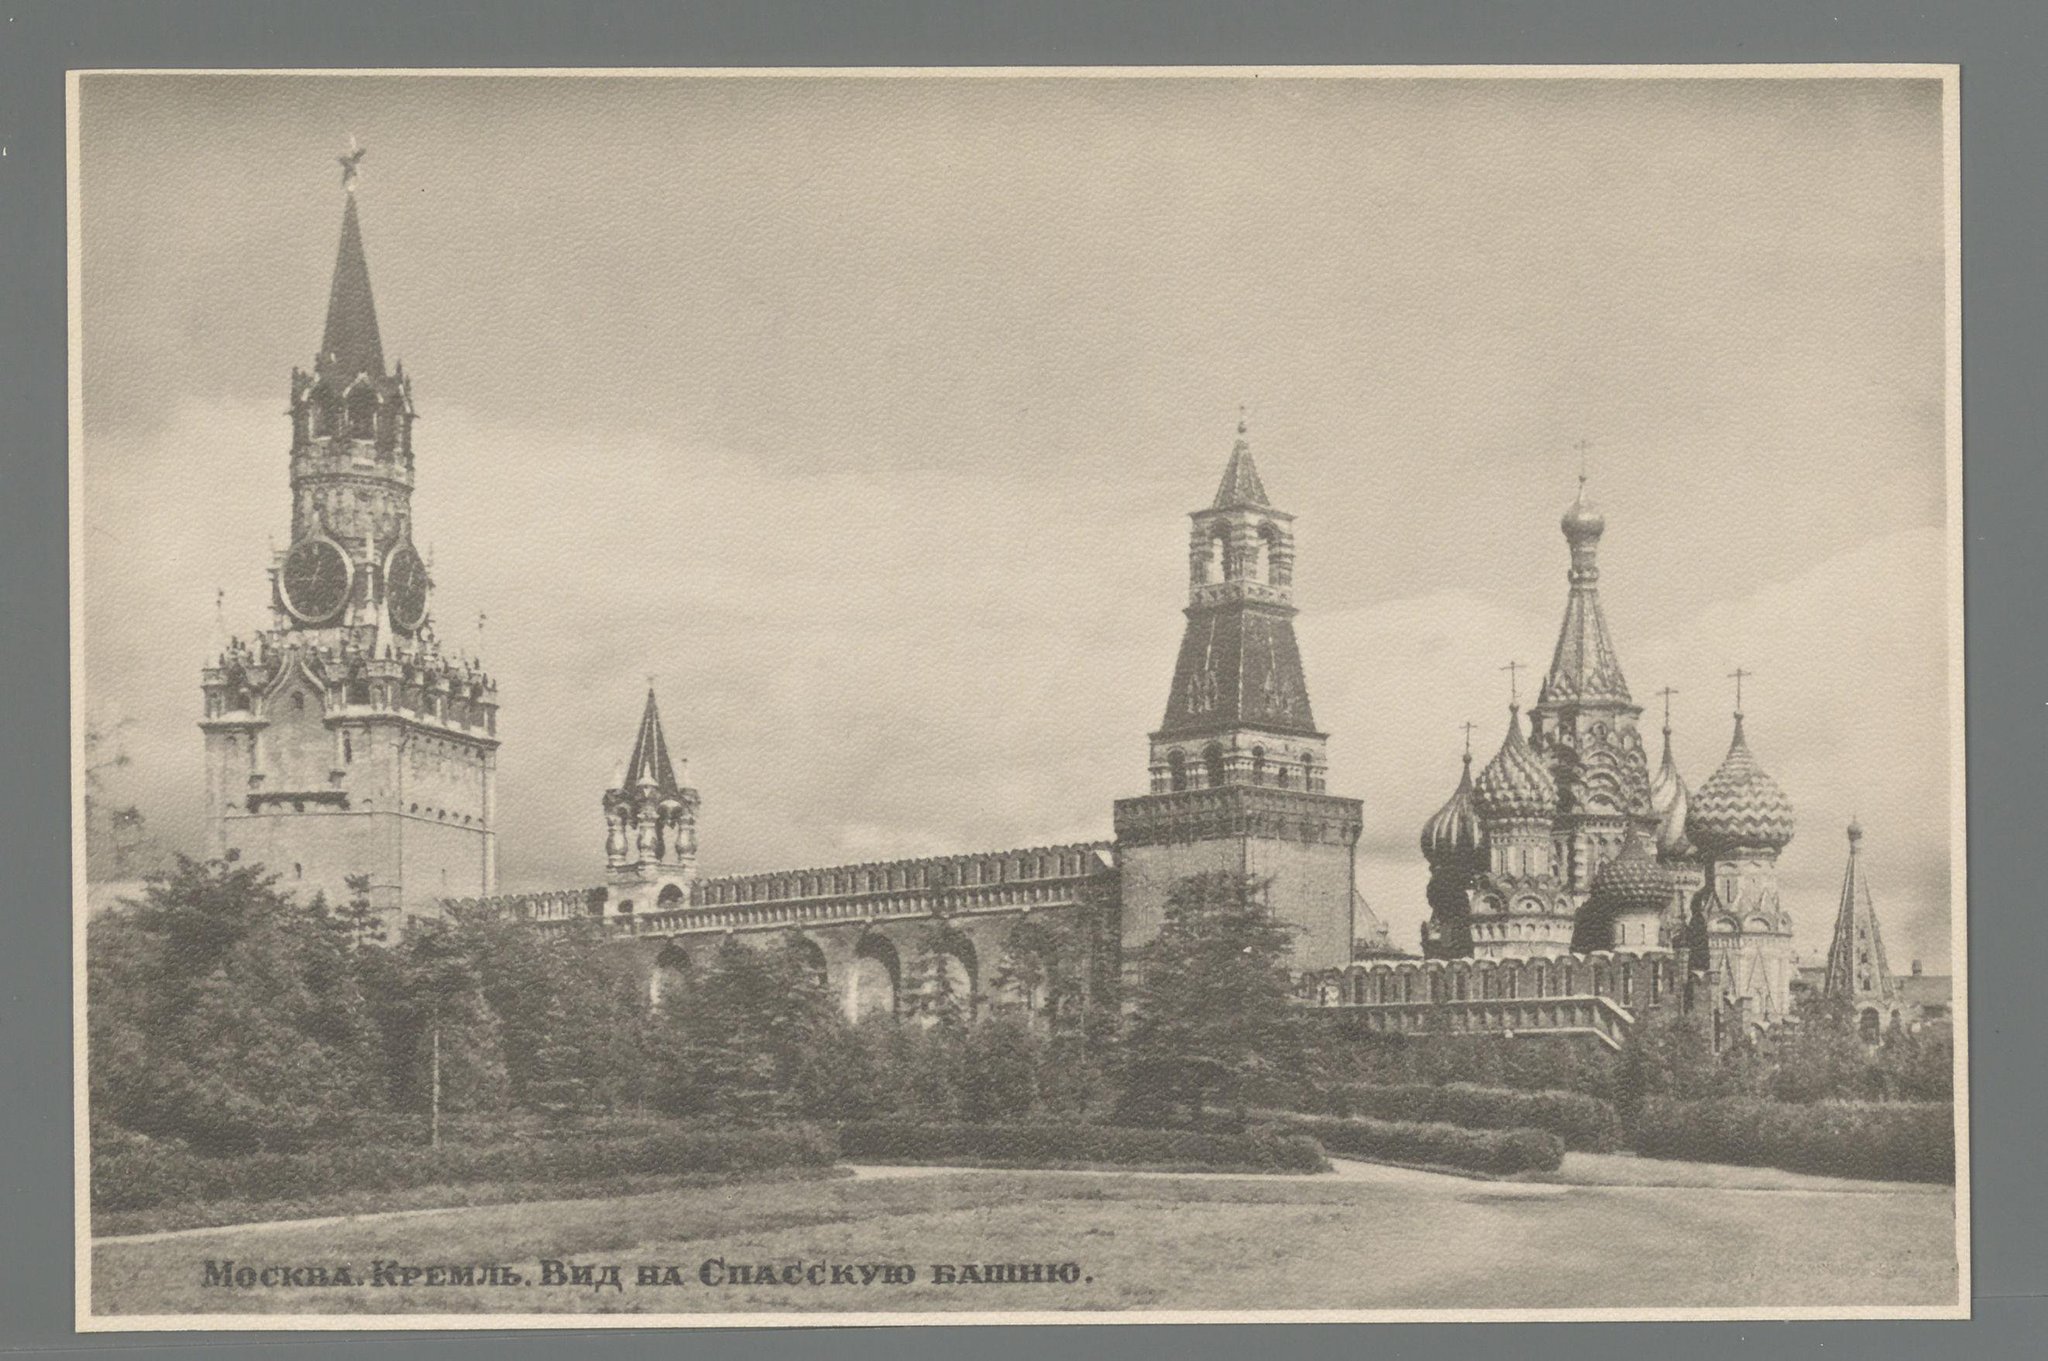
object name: ansichtkaart, prentbriefkaart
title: Gezicht op de Spasskajatoren in het Kremlin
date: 1954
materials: paper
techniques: gelatin silver print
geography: moscow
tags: towers ~ fortified city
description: De titel op object staat in het Russisch.